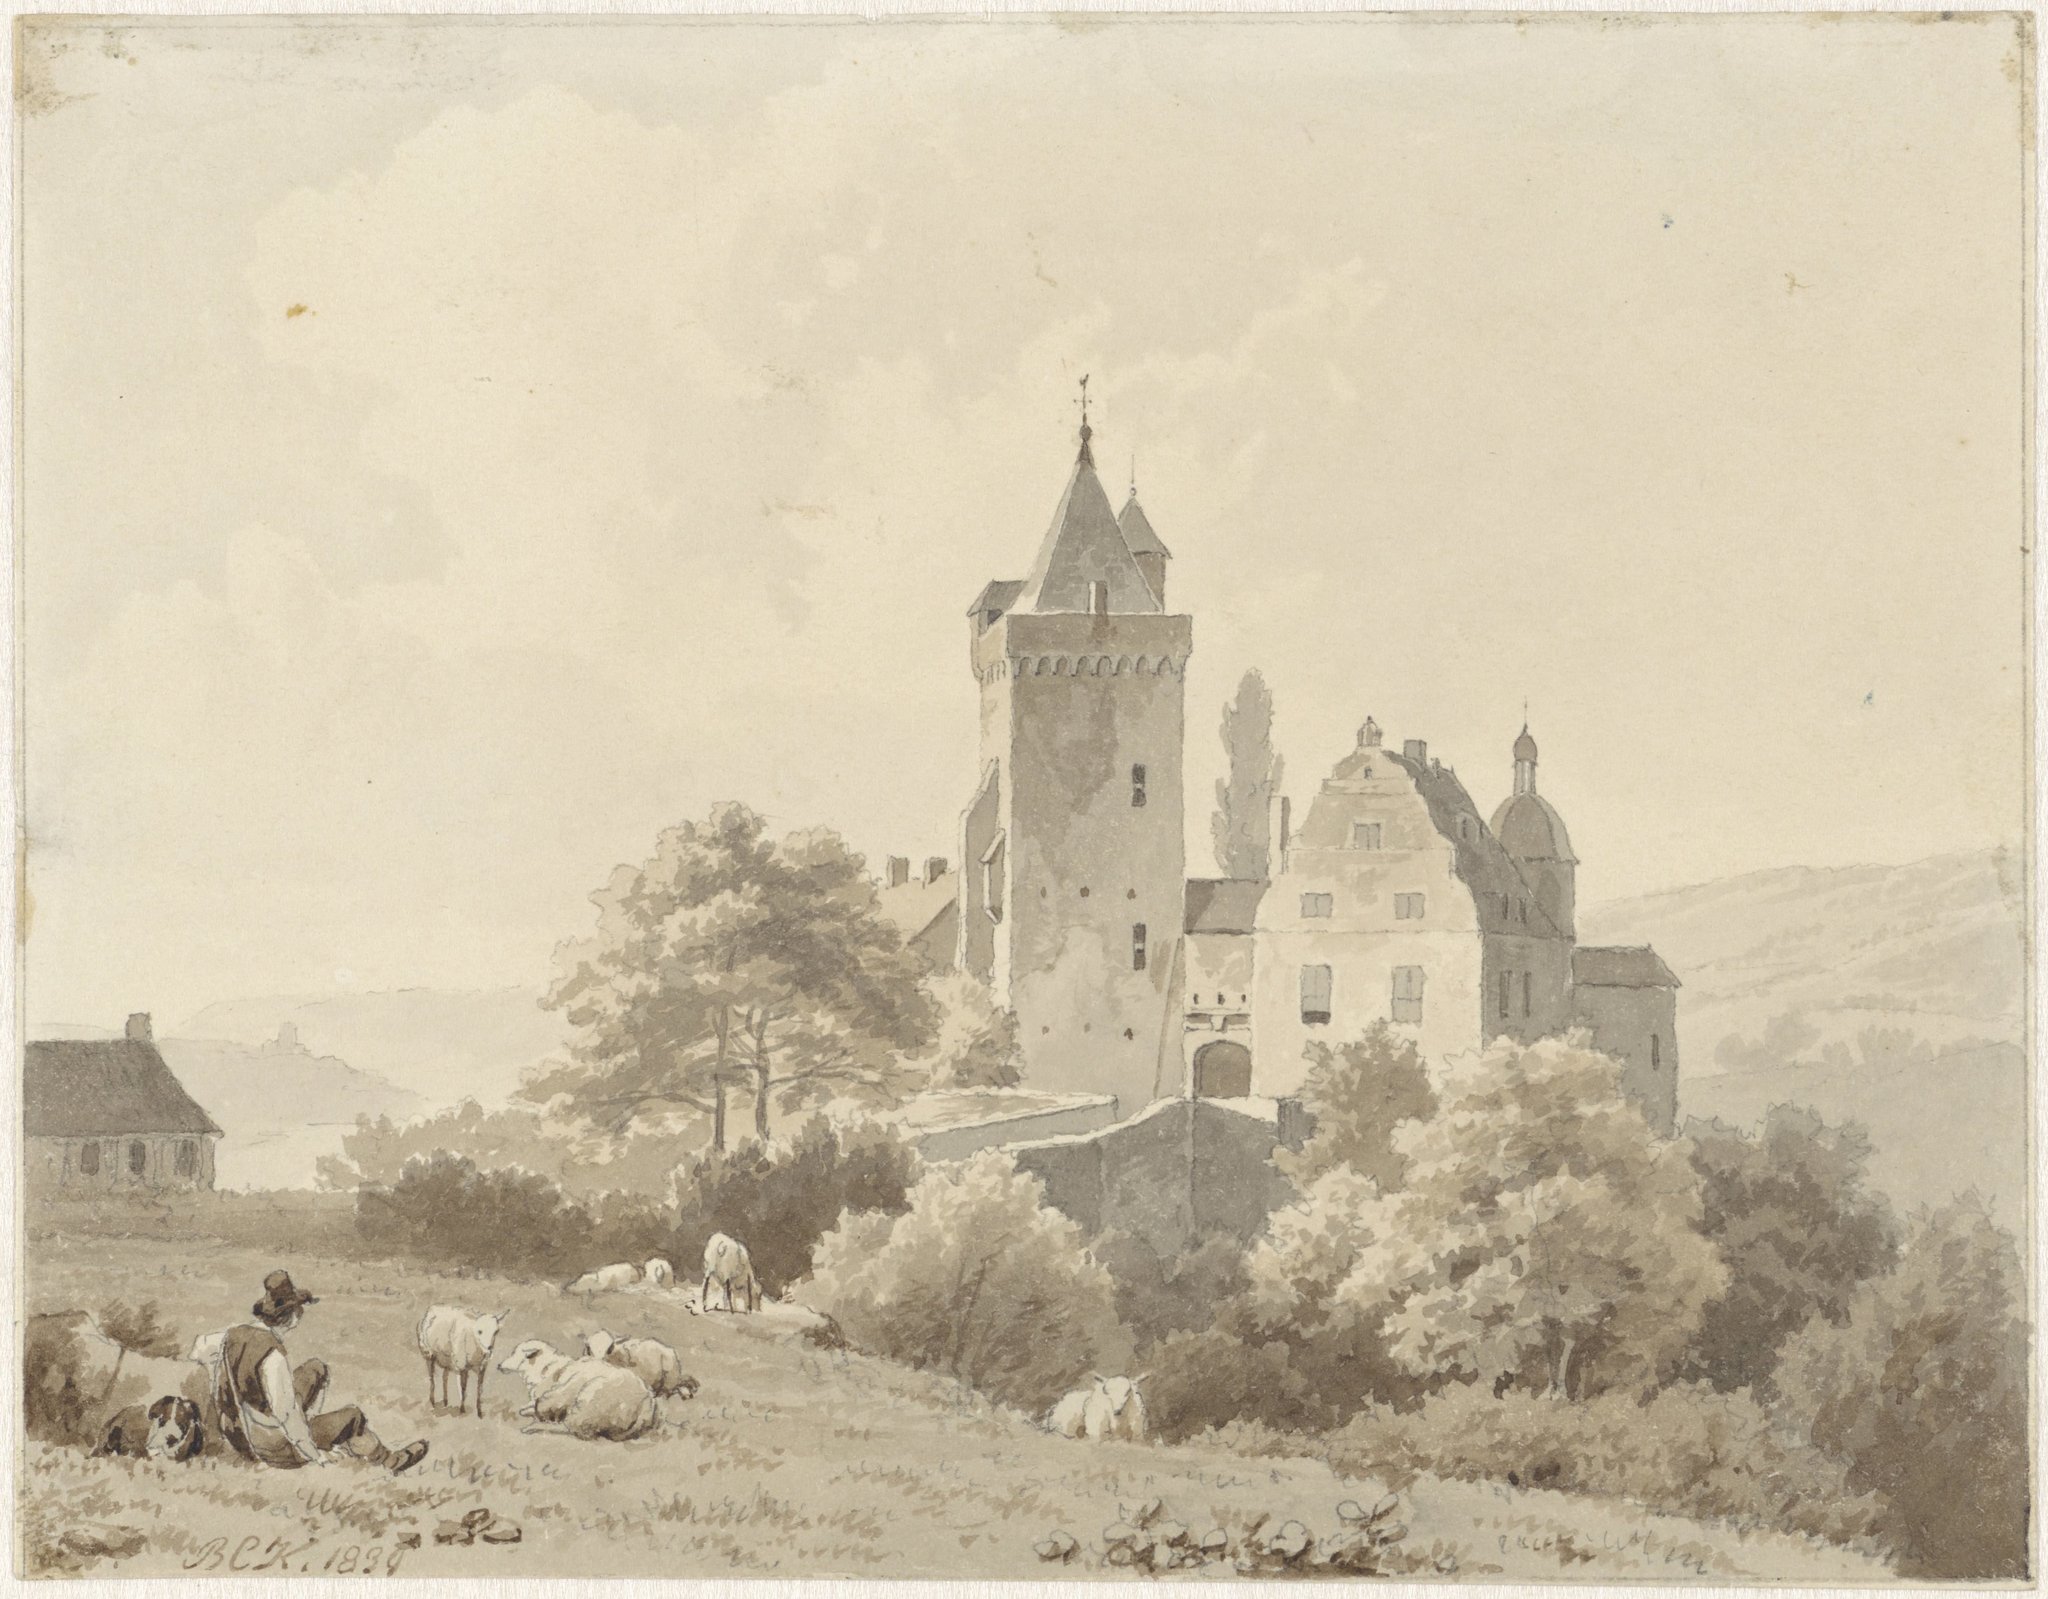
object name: drawing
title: Rustende herder bij Schloss Lansberg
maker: barend cornelis koekkoek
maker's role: draughtsman, painter, print maker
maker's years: 1803-1862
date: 1839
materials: ink, paper, pencil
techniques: brush, pen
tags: castle, farm or solitary house in landscape, germany